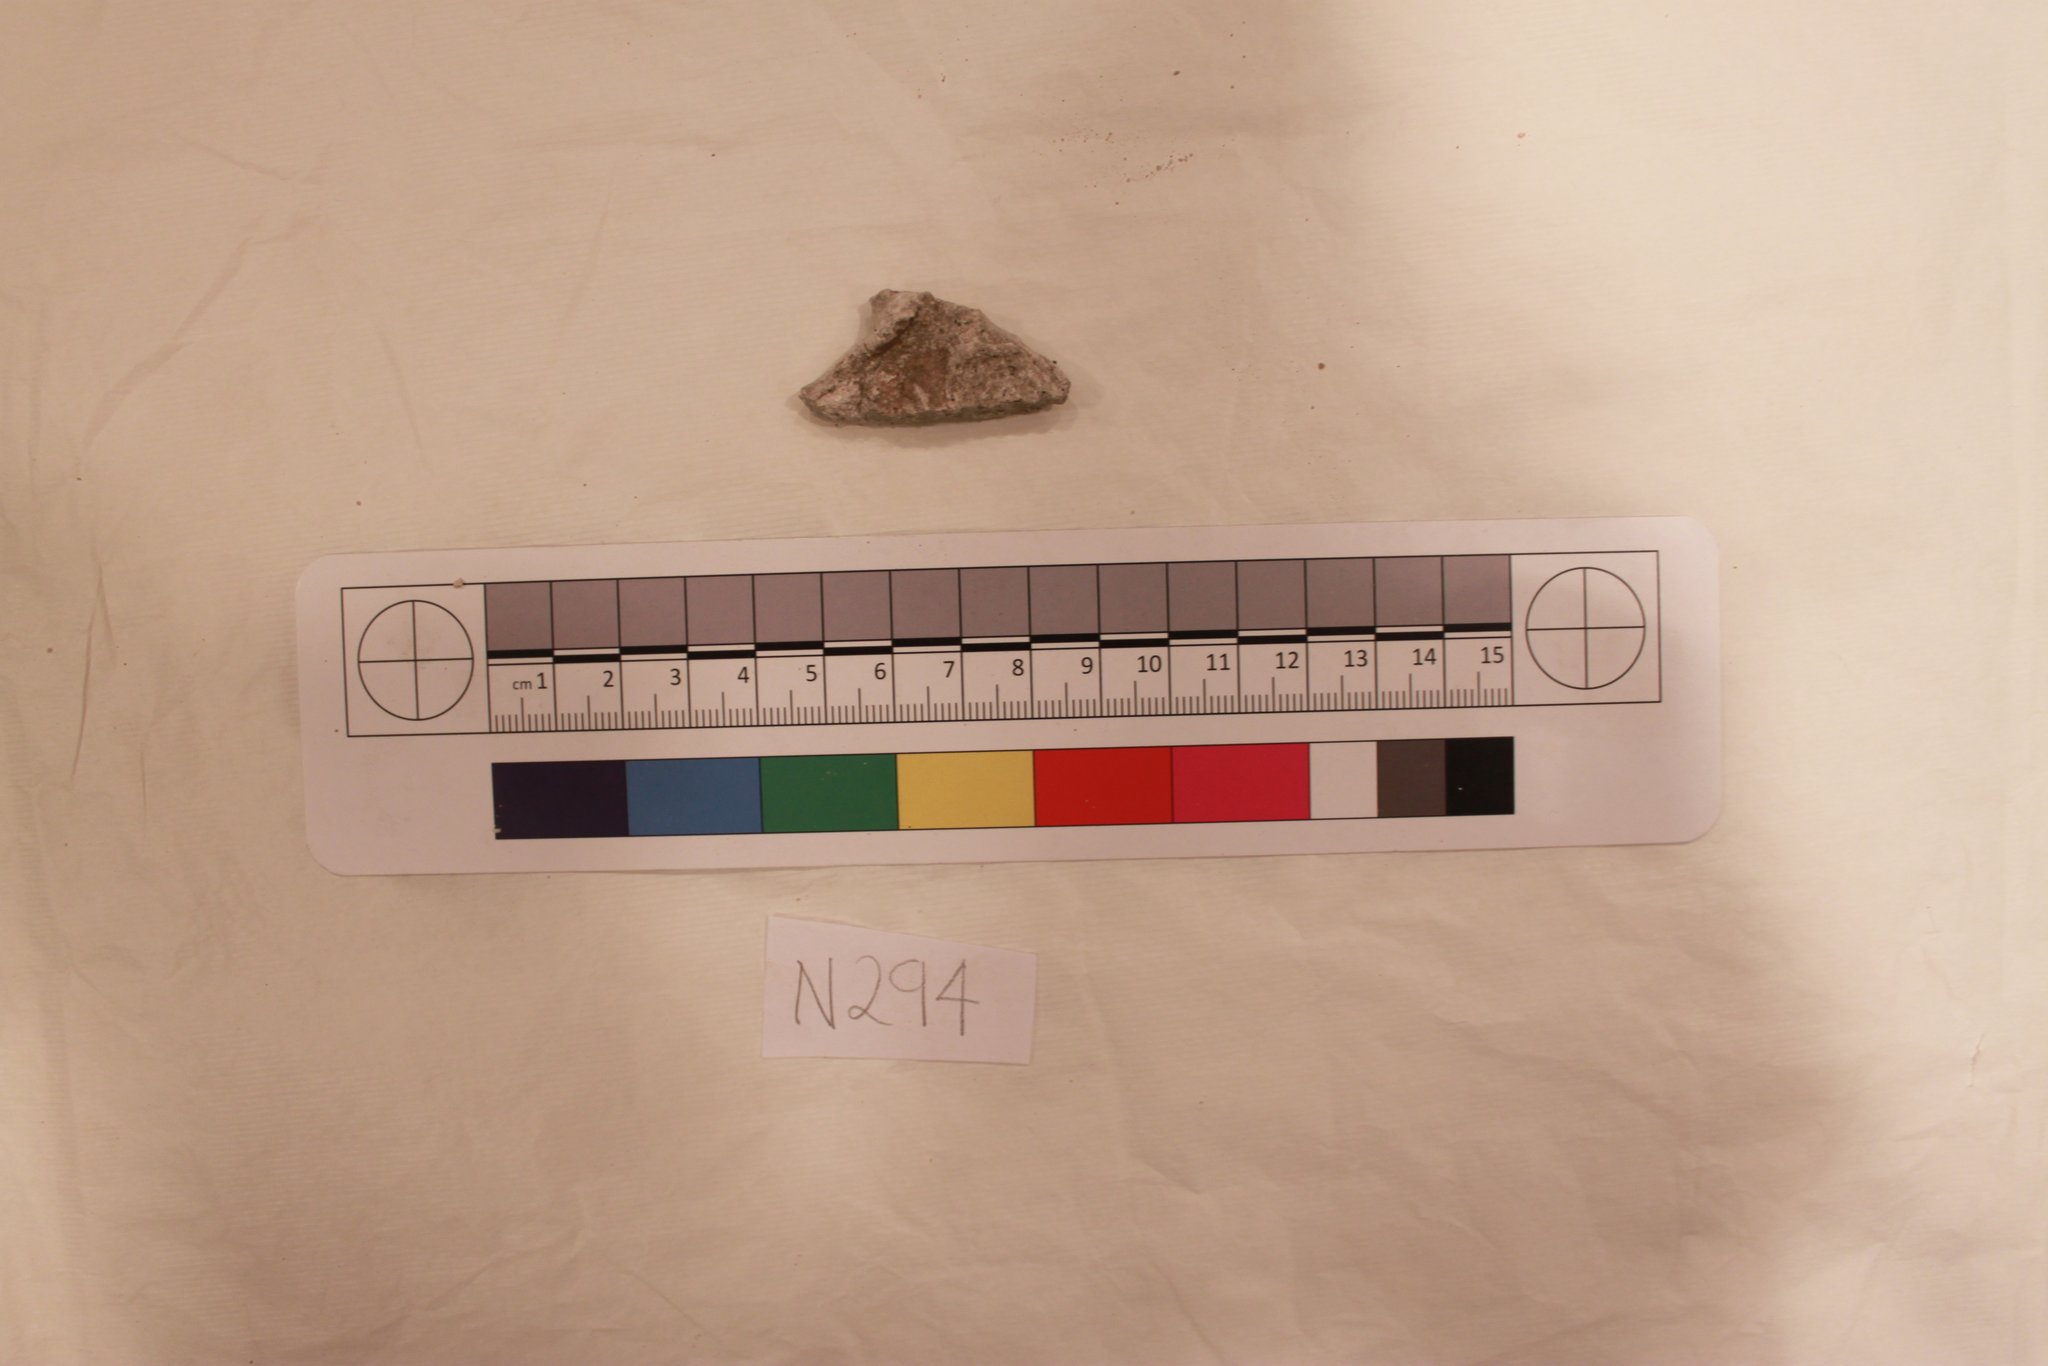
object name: fragment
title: Stucco Fragment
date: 701-1200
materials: plaster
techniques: carving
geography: iran